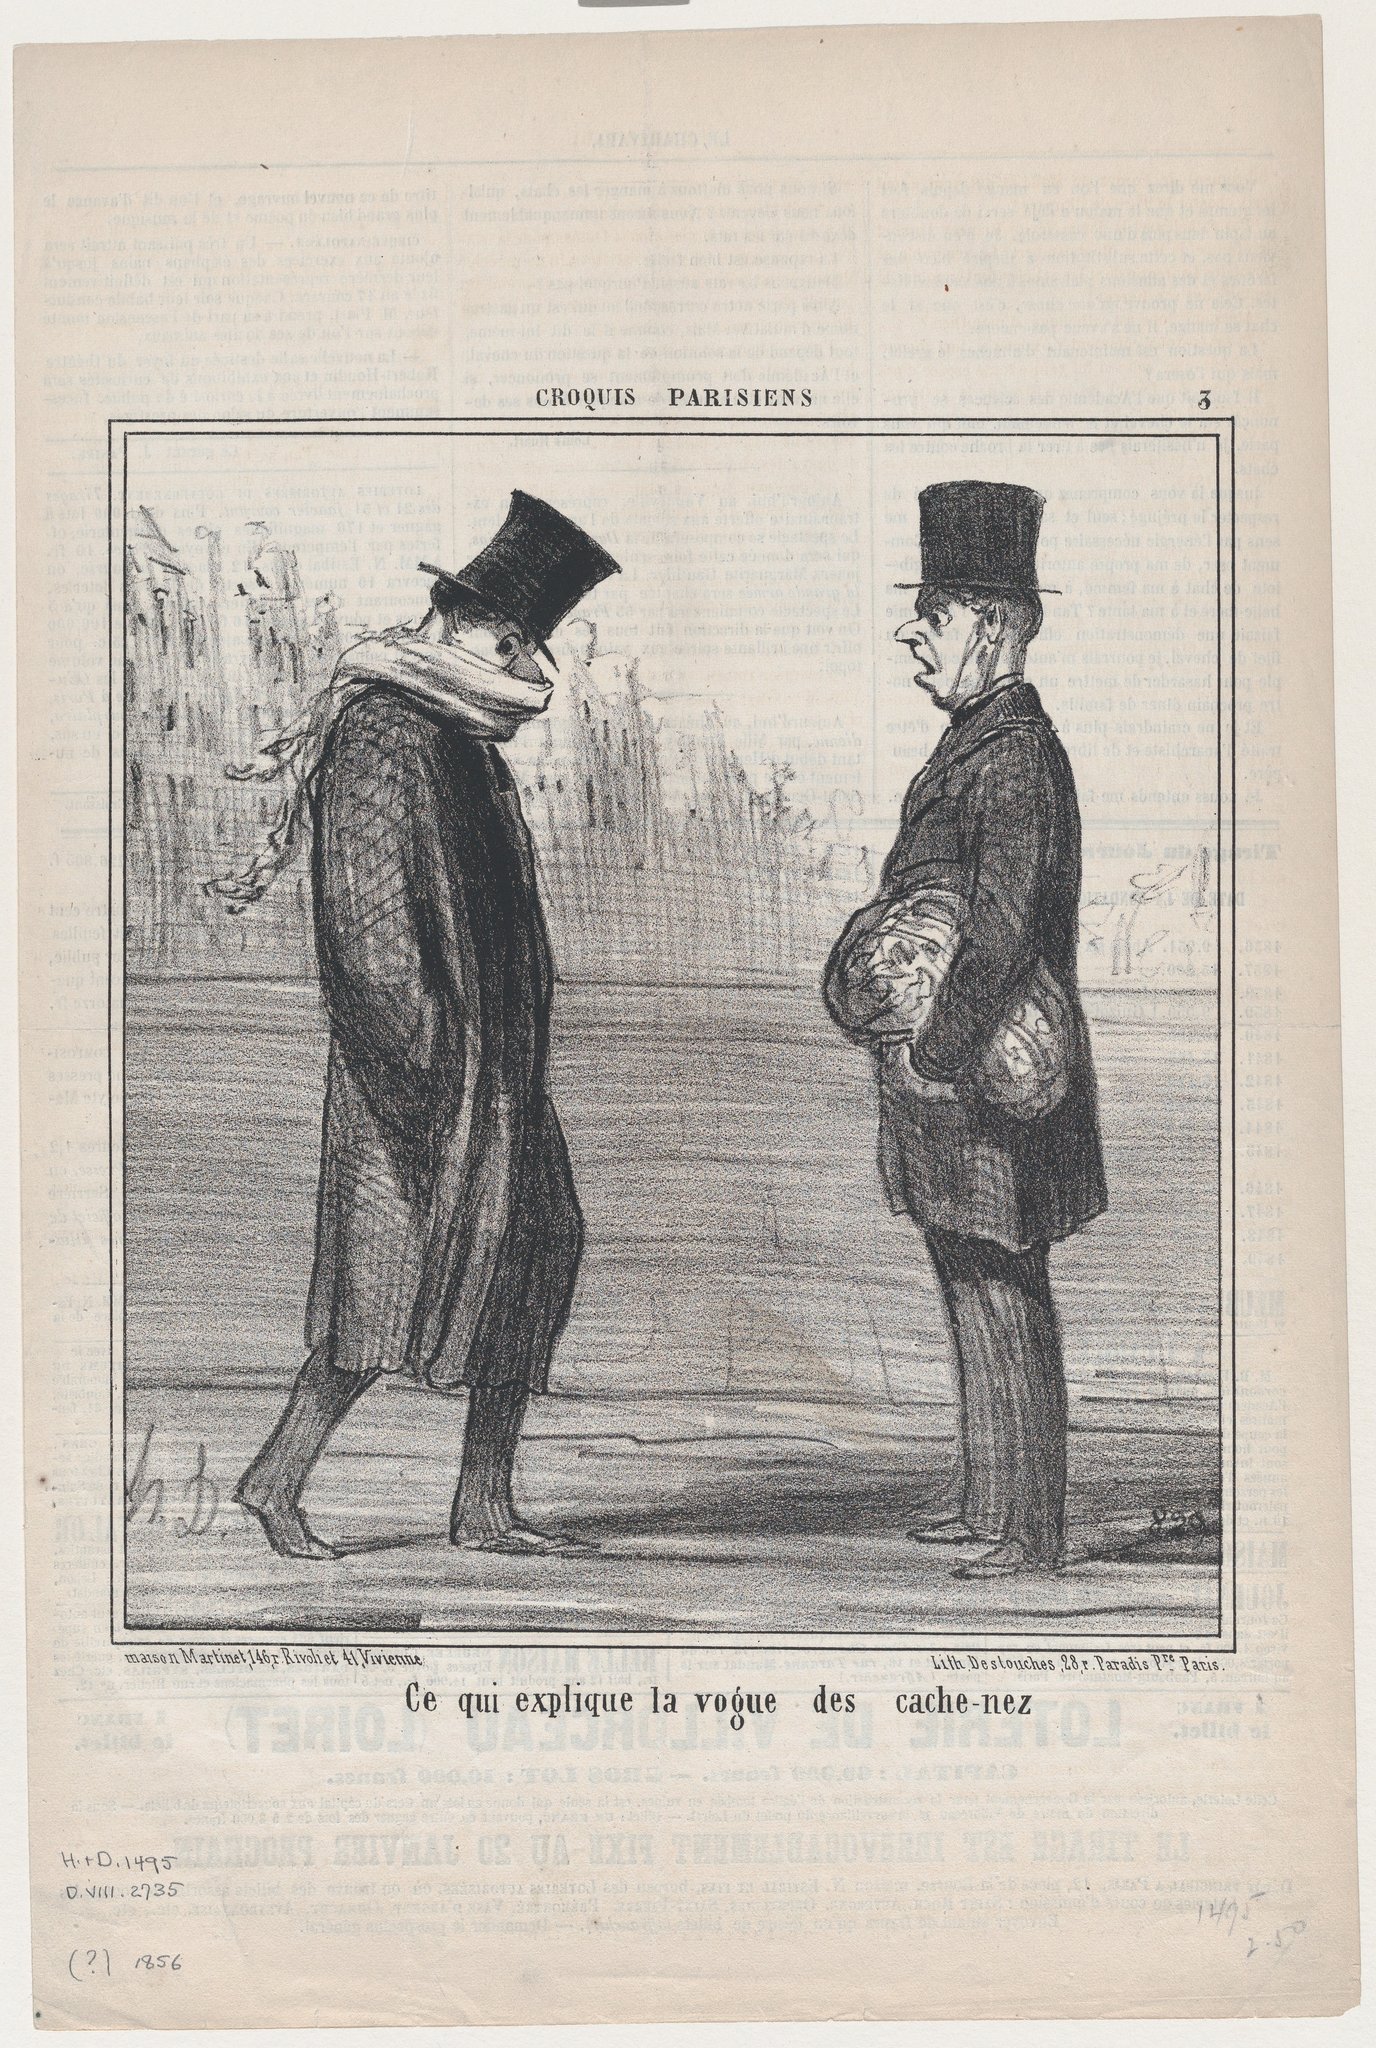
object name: print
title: Ce qui explique la voue des cache-nez, from "Croquis Parisiens"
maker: honoré daumier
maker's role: artist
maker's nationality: french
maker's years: 1808-1879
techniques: lithograph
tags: men